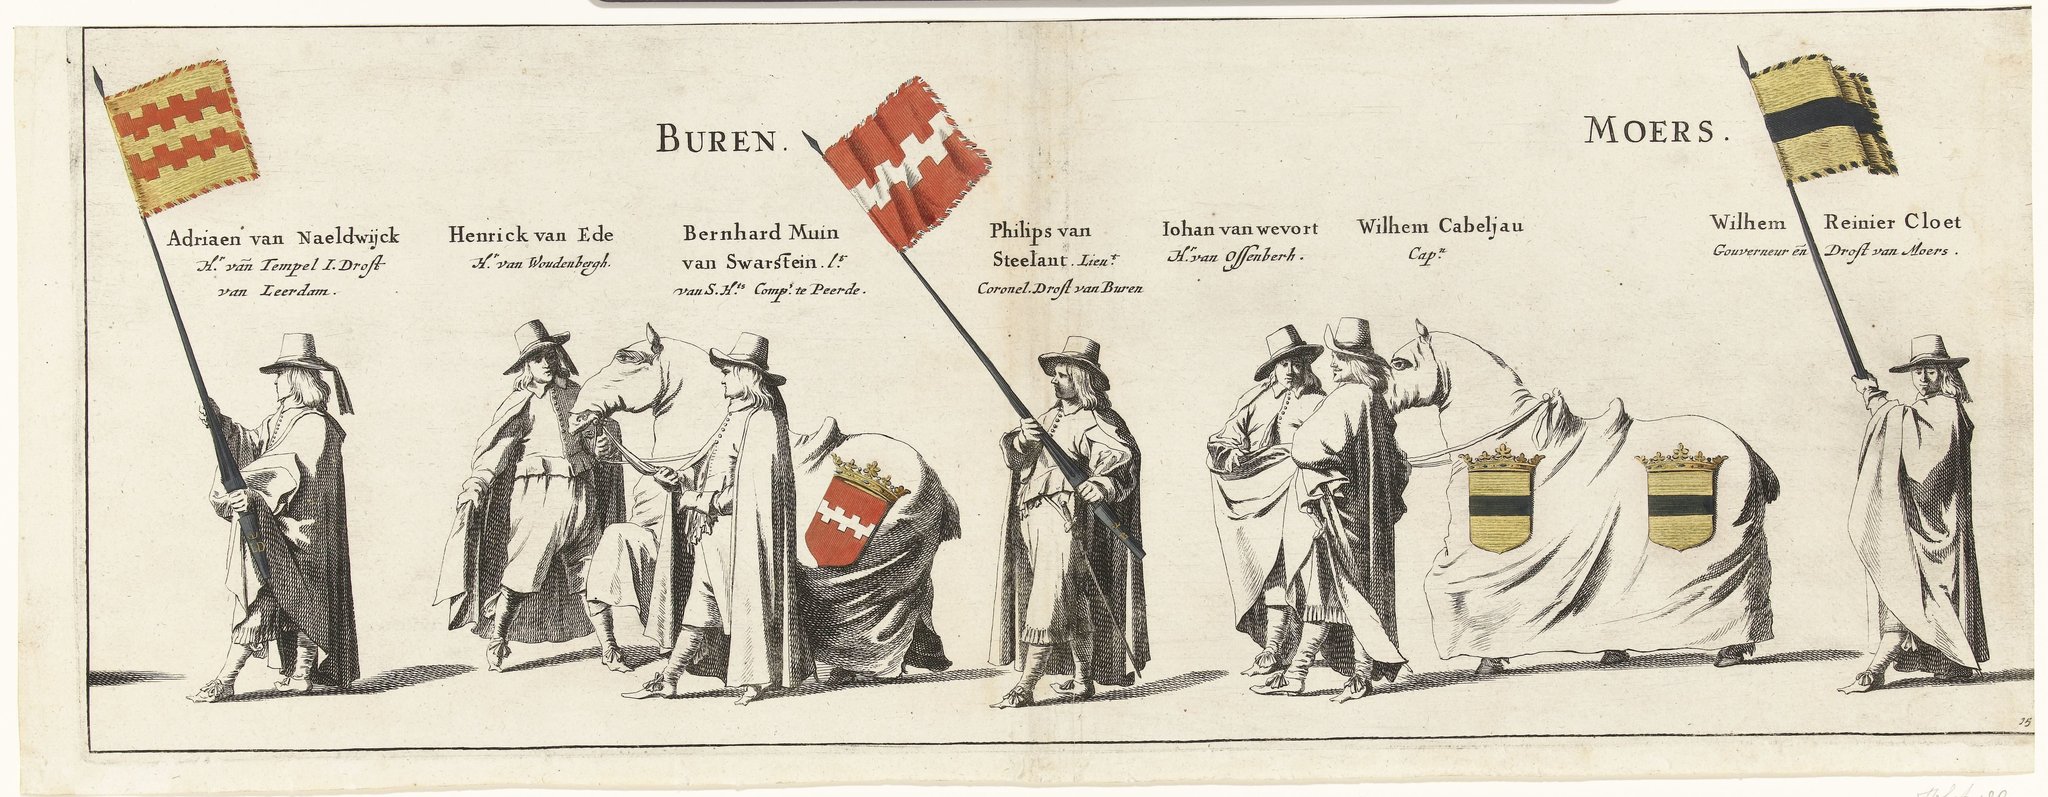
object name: print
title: De begrafenisstoet van Frederik Hendrik (plaat nr. 15), 1647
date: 1647-1651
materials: paper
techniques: etching, hand coloring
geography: amsterdam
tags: delft, the hague, frederick henry (prince of orange), cortege, funeral procession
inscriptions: collector's mark: Lugt 2228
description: De begrafenisstoet van stadhouder Frederik Hendrik te 's-Gravenhage op 10 mei 1647. Plaat nr. 15 met een deel van de stoet met vaandeldragers en twee paarden, boven de personen staan hun naam en functie. Onderdeel van een serie van 30 platen en 20 tekstbladen, bedoeld om aan elkaar geplakt te worden.